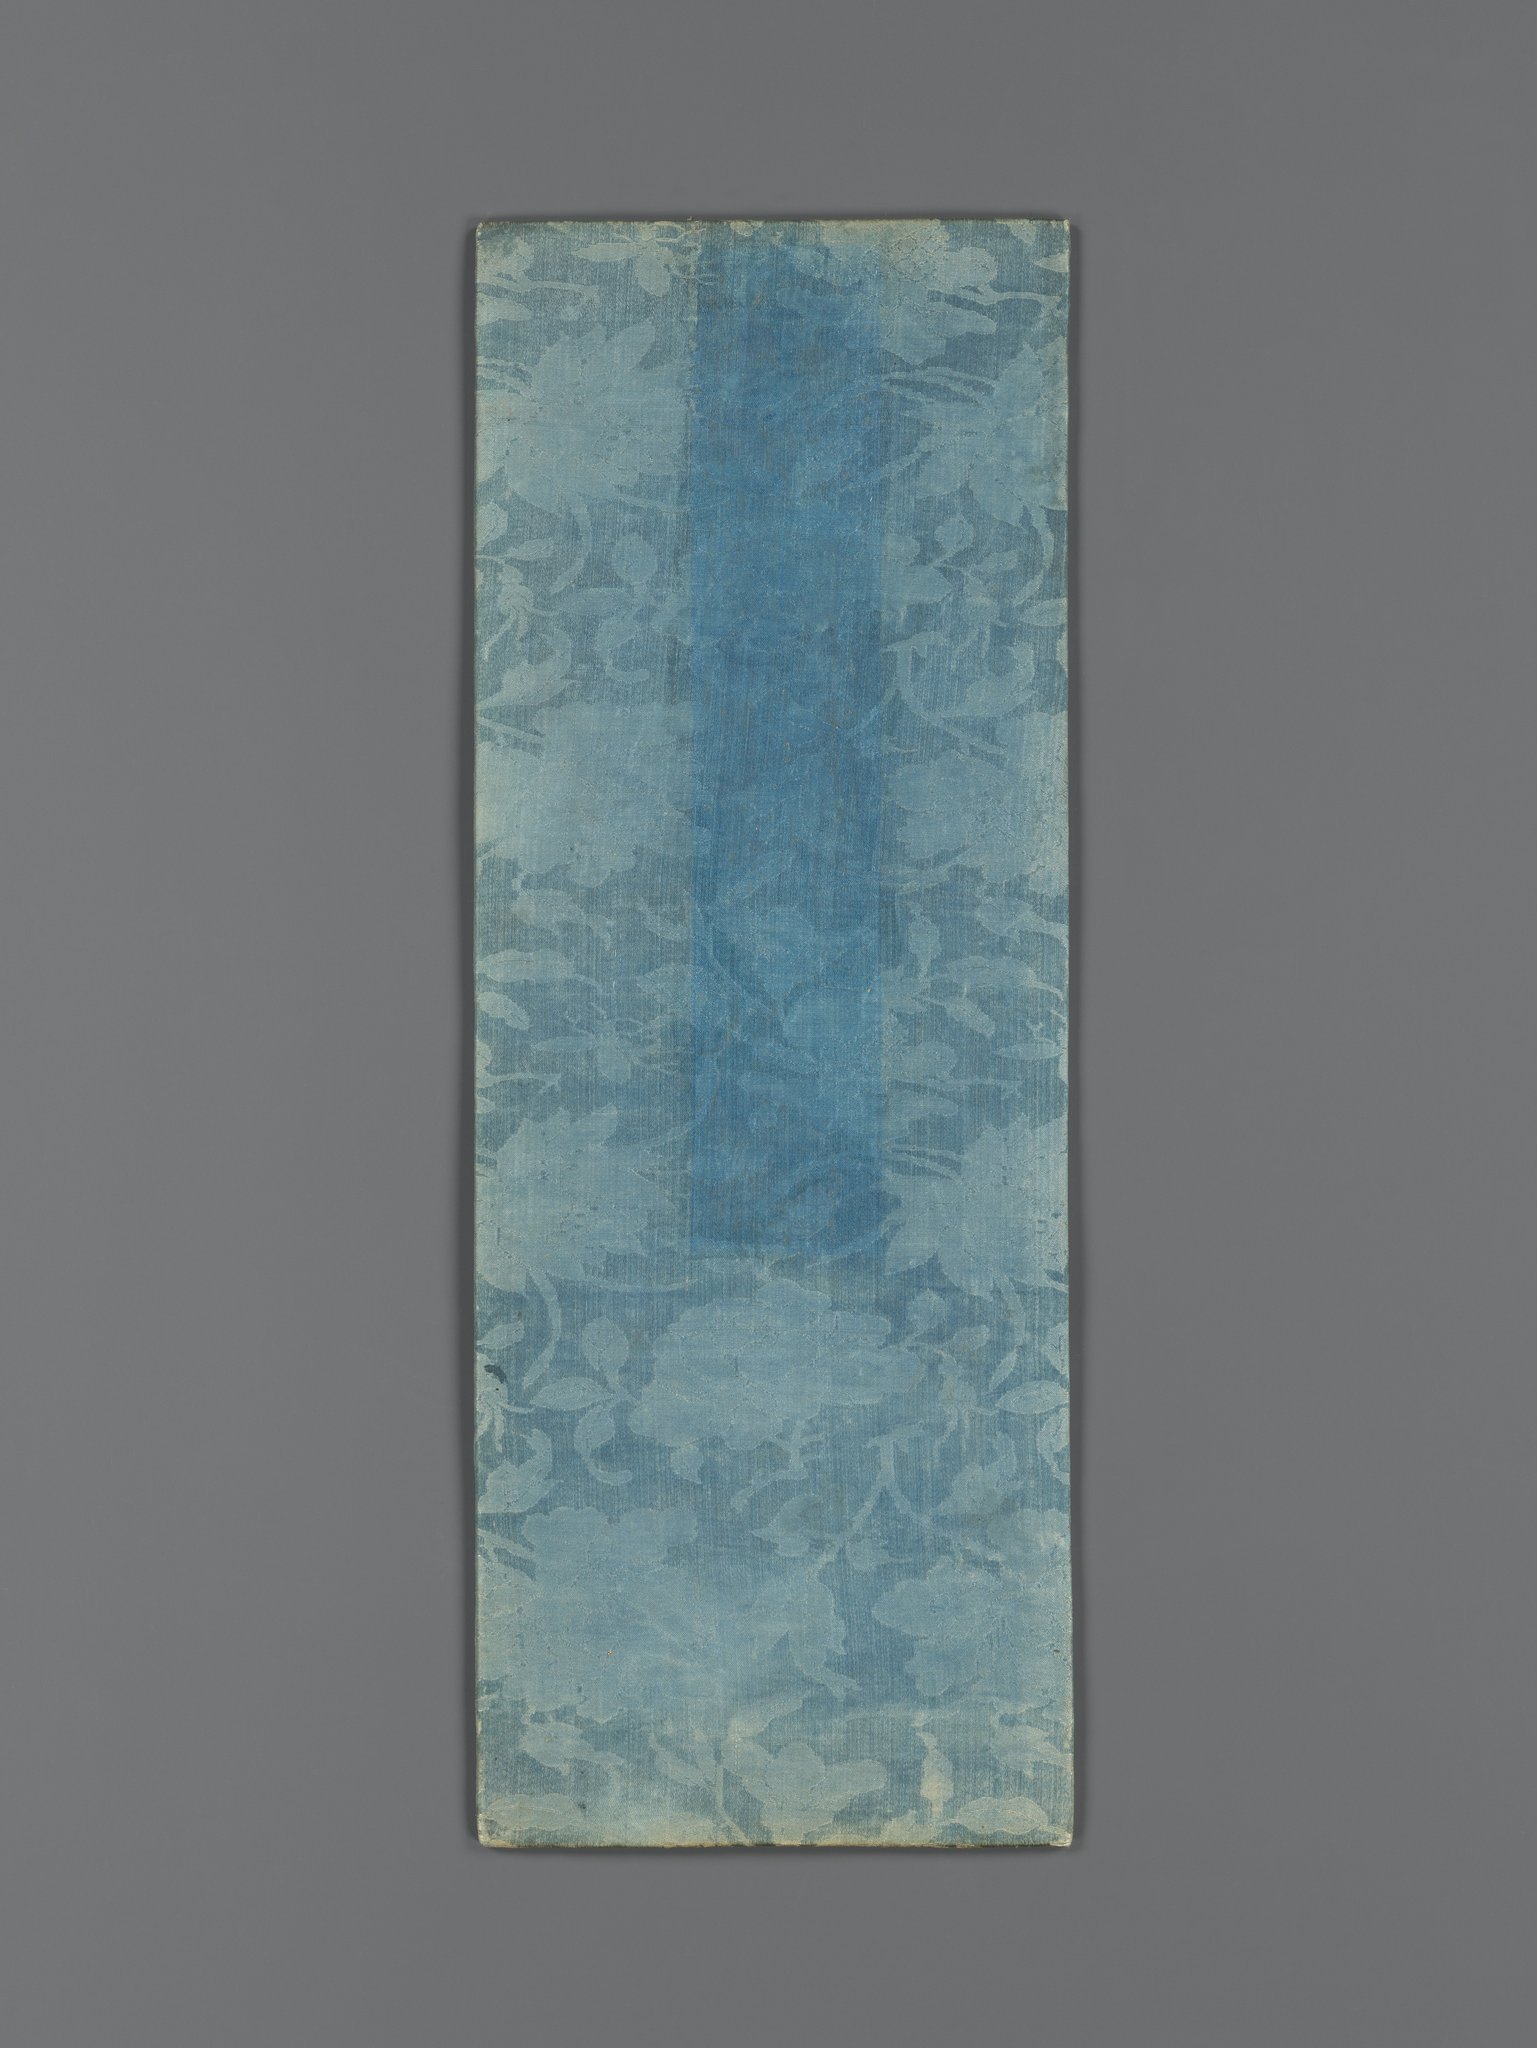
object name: sutra cover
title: Sutra Cover with Floral Pattern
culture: chinese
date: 1501-1600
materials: silk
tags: flowers,leaves